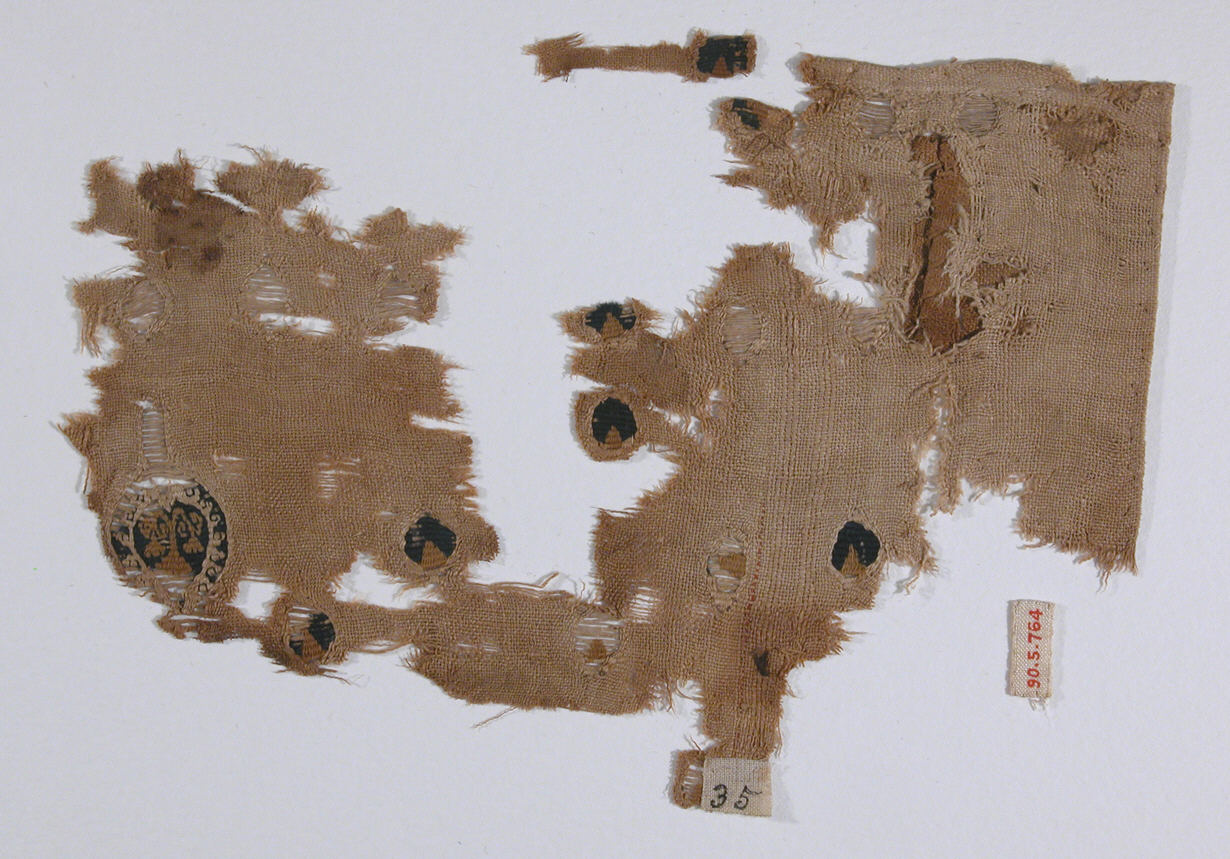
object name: textile fragment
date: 401-500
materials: linen, wool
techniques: weave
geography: egypt